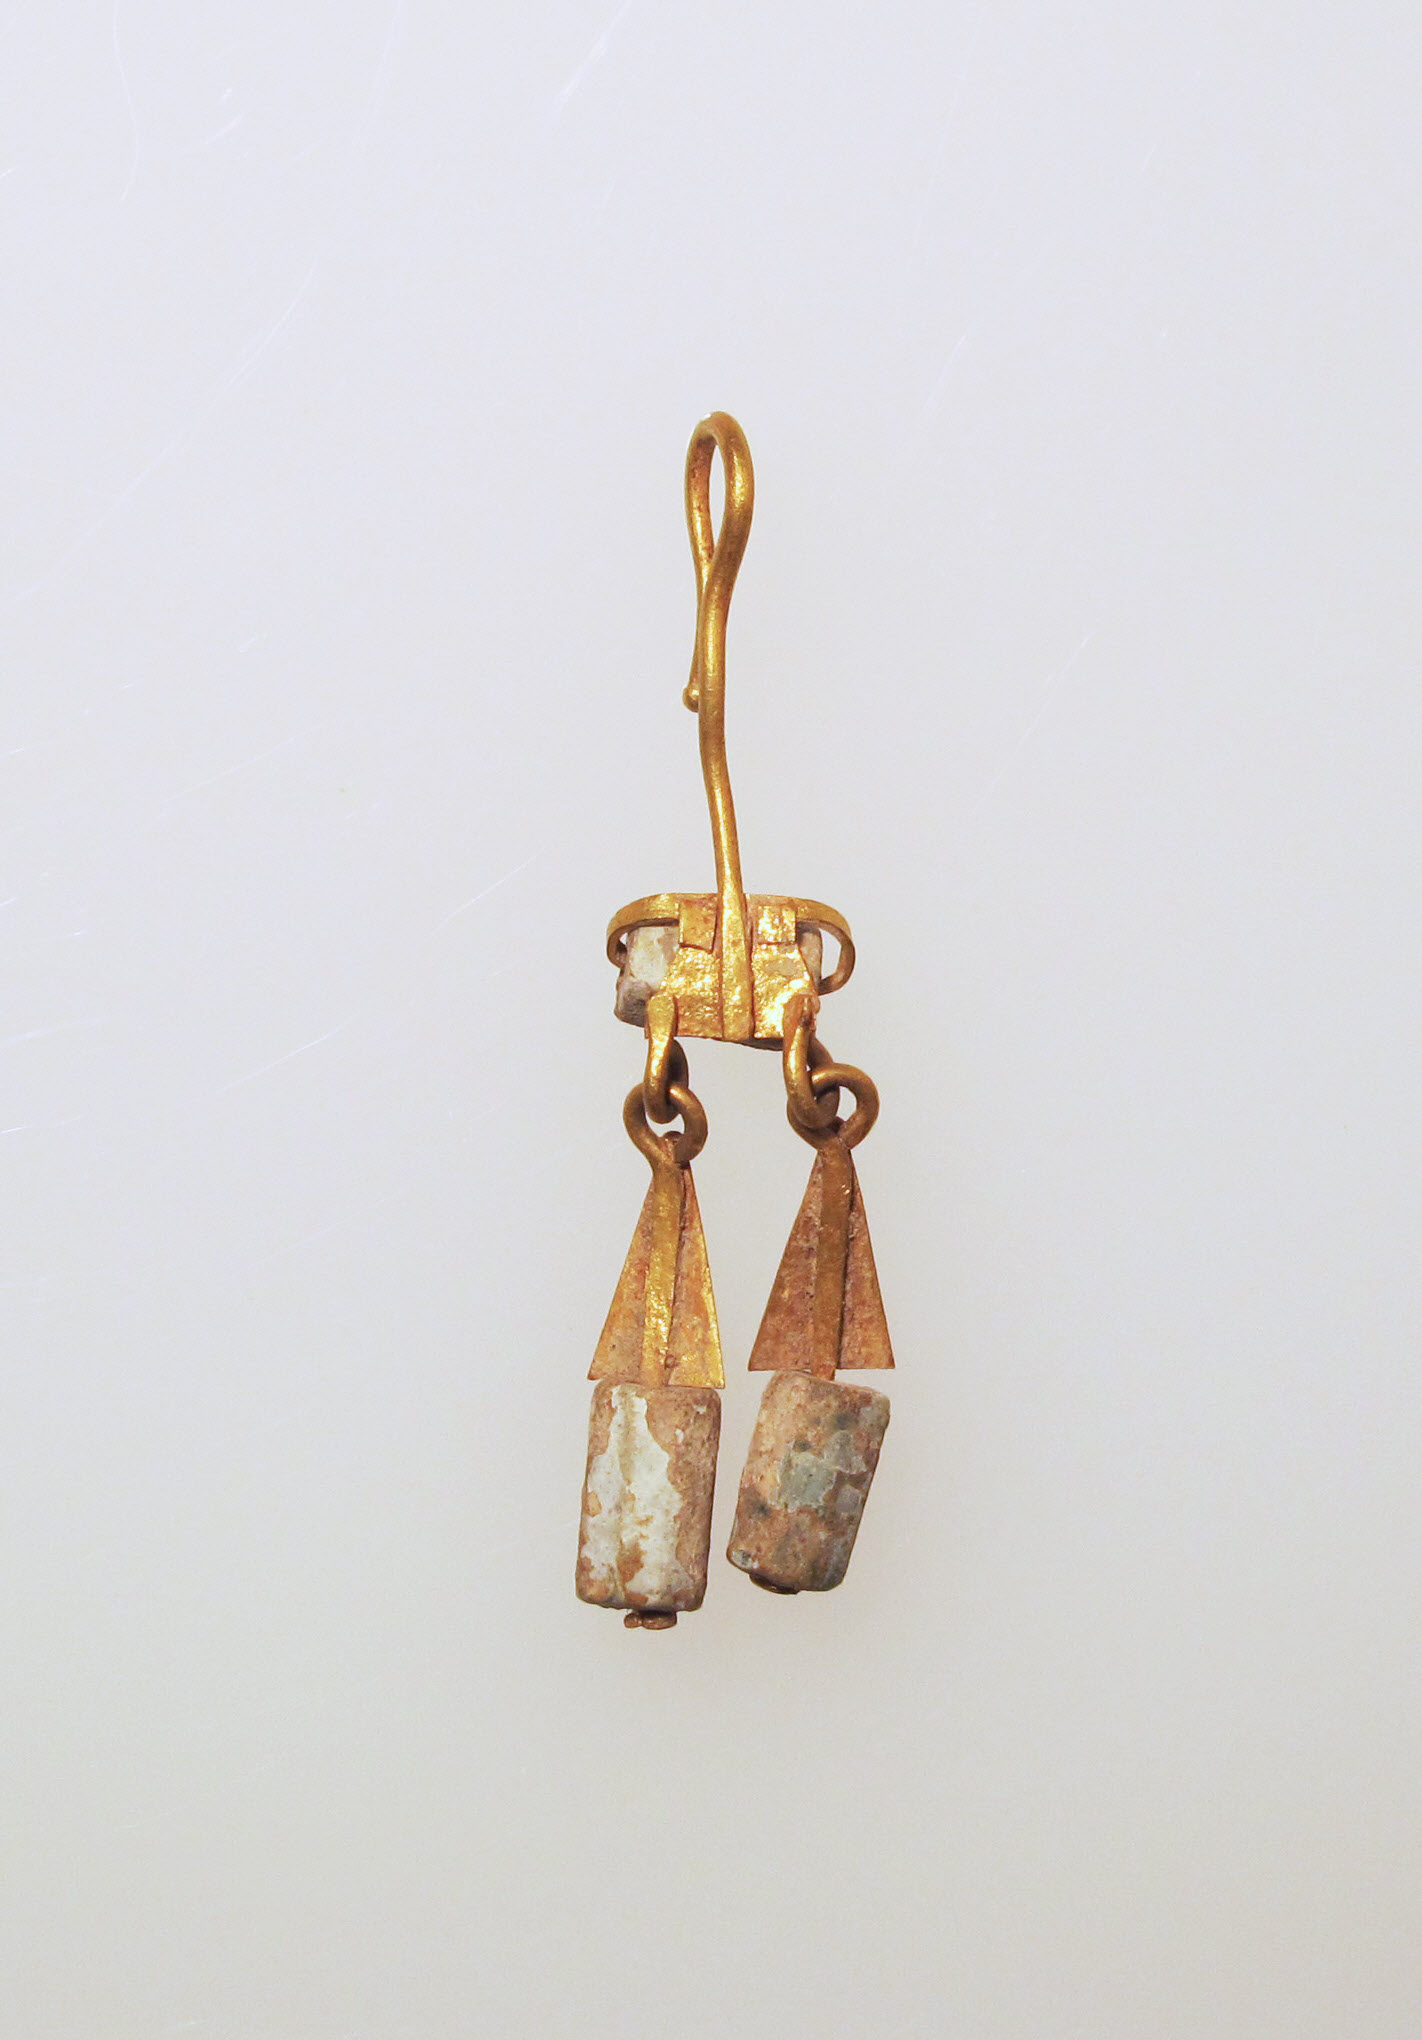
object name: earring hook type with pendant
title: Earring-hook type, with pendants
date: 7000 BCE-330 CE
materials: gold